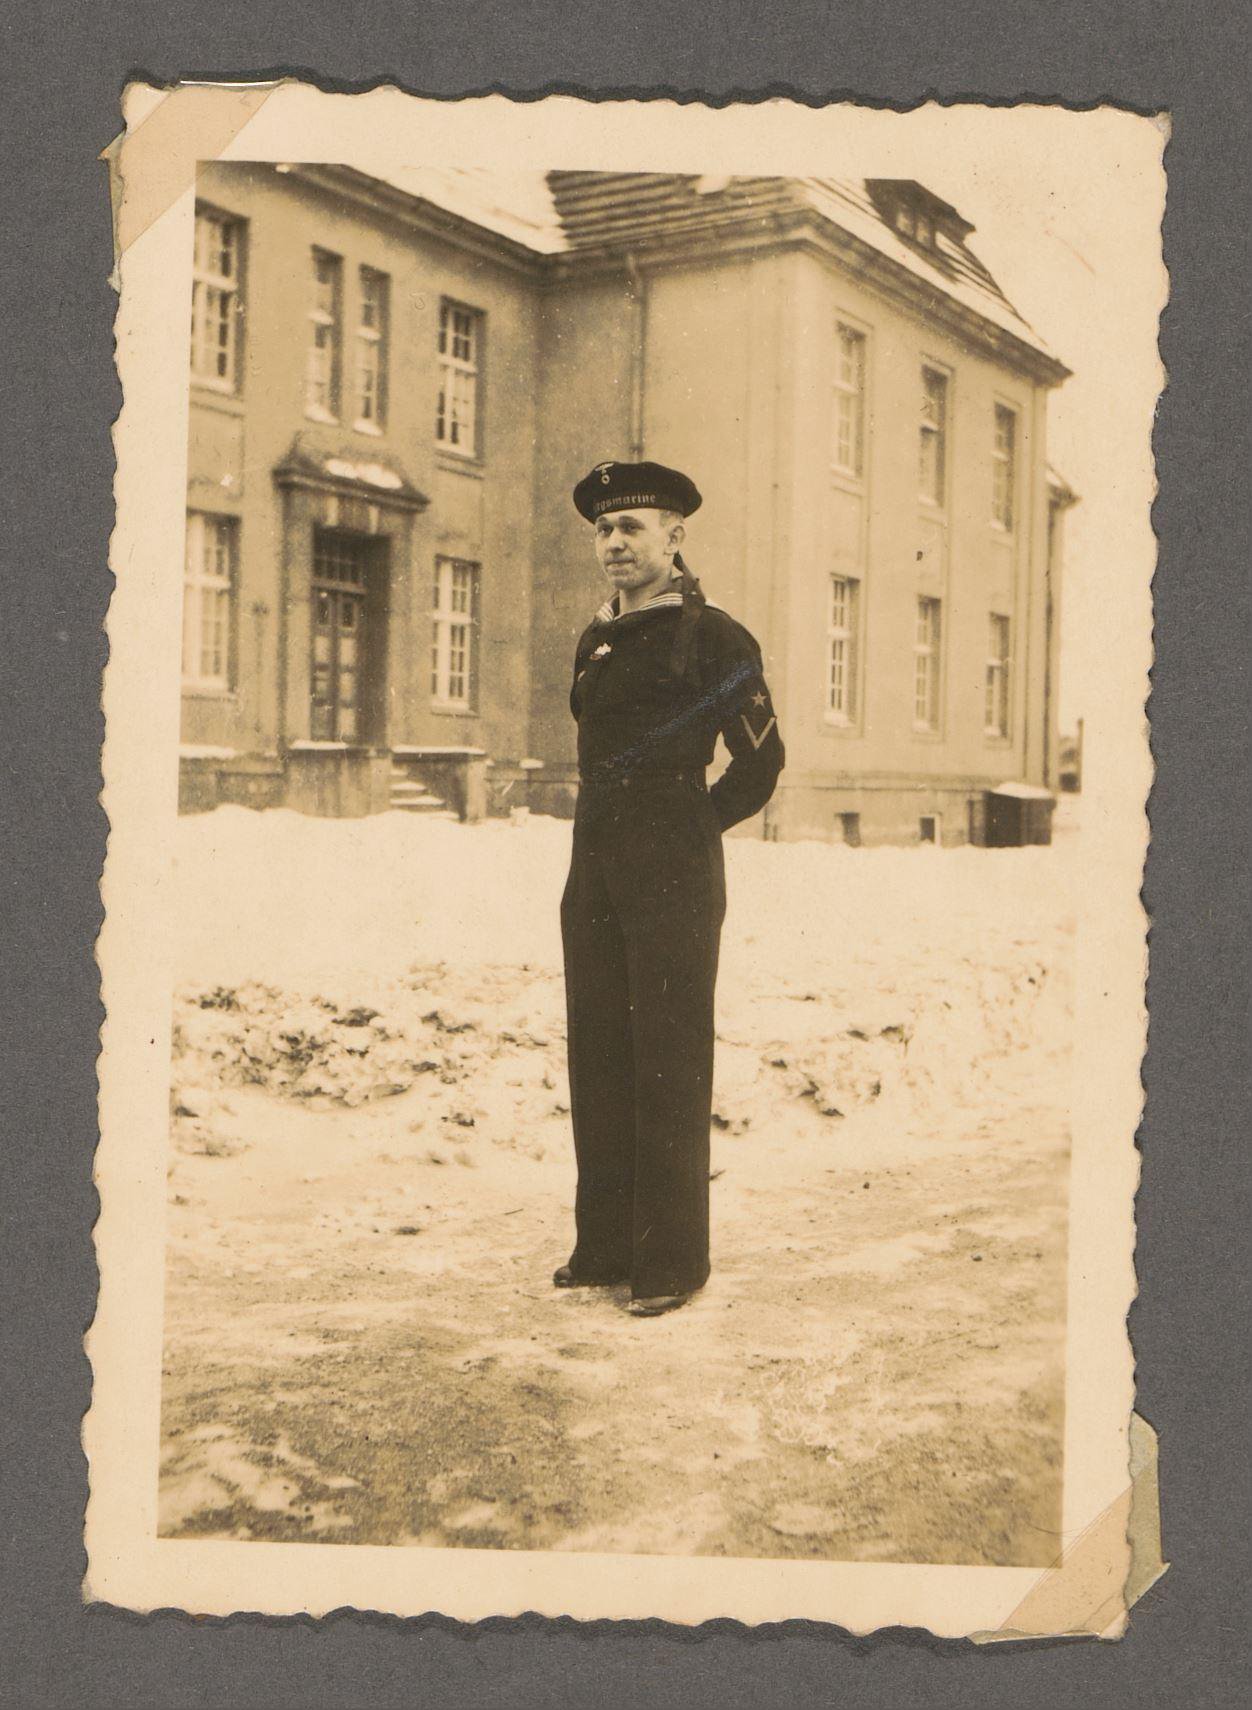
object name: photograph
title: Portret van een militair in uniform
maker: Anonymous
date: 1941-1945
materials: paper, photographic support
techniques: gelatin silver print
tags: adult man, historical persons, the soldier; the soldier's life, (military) uniforms